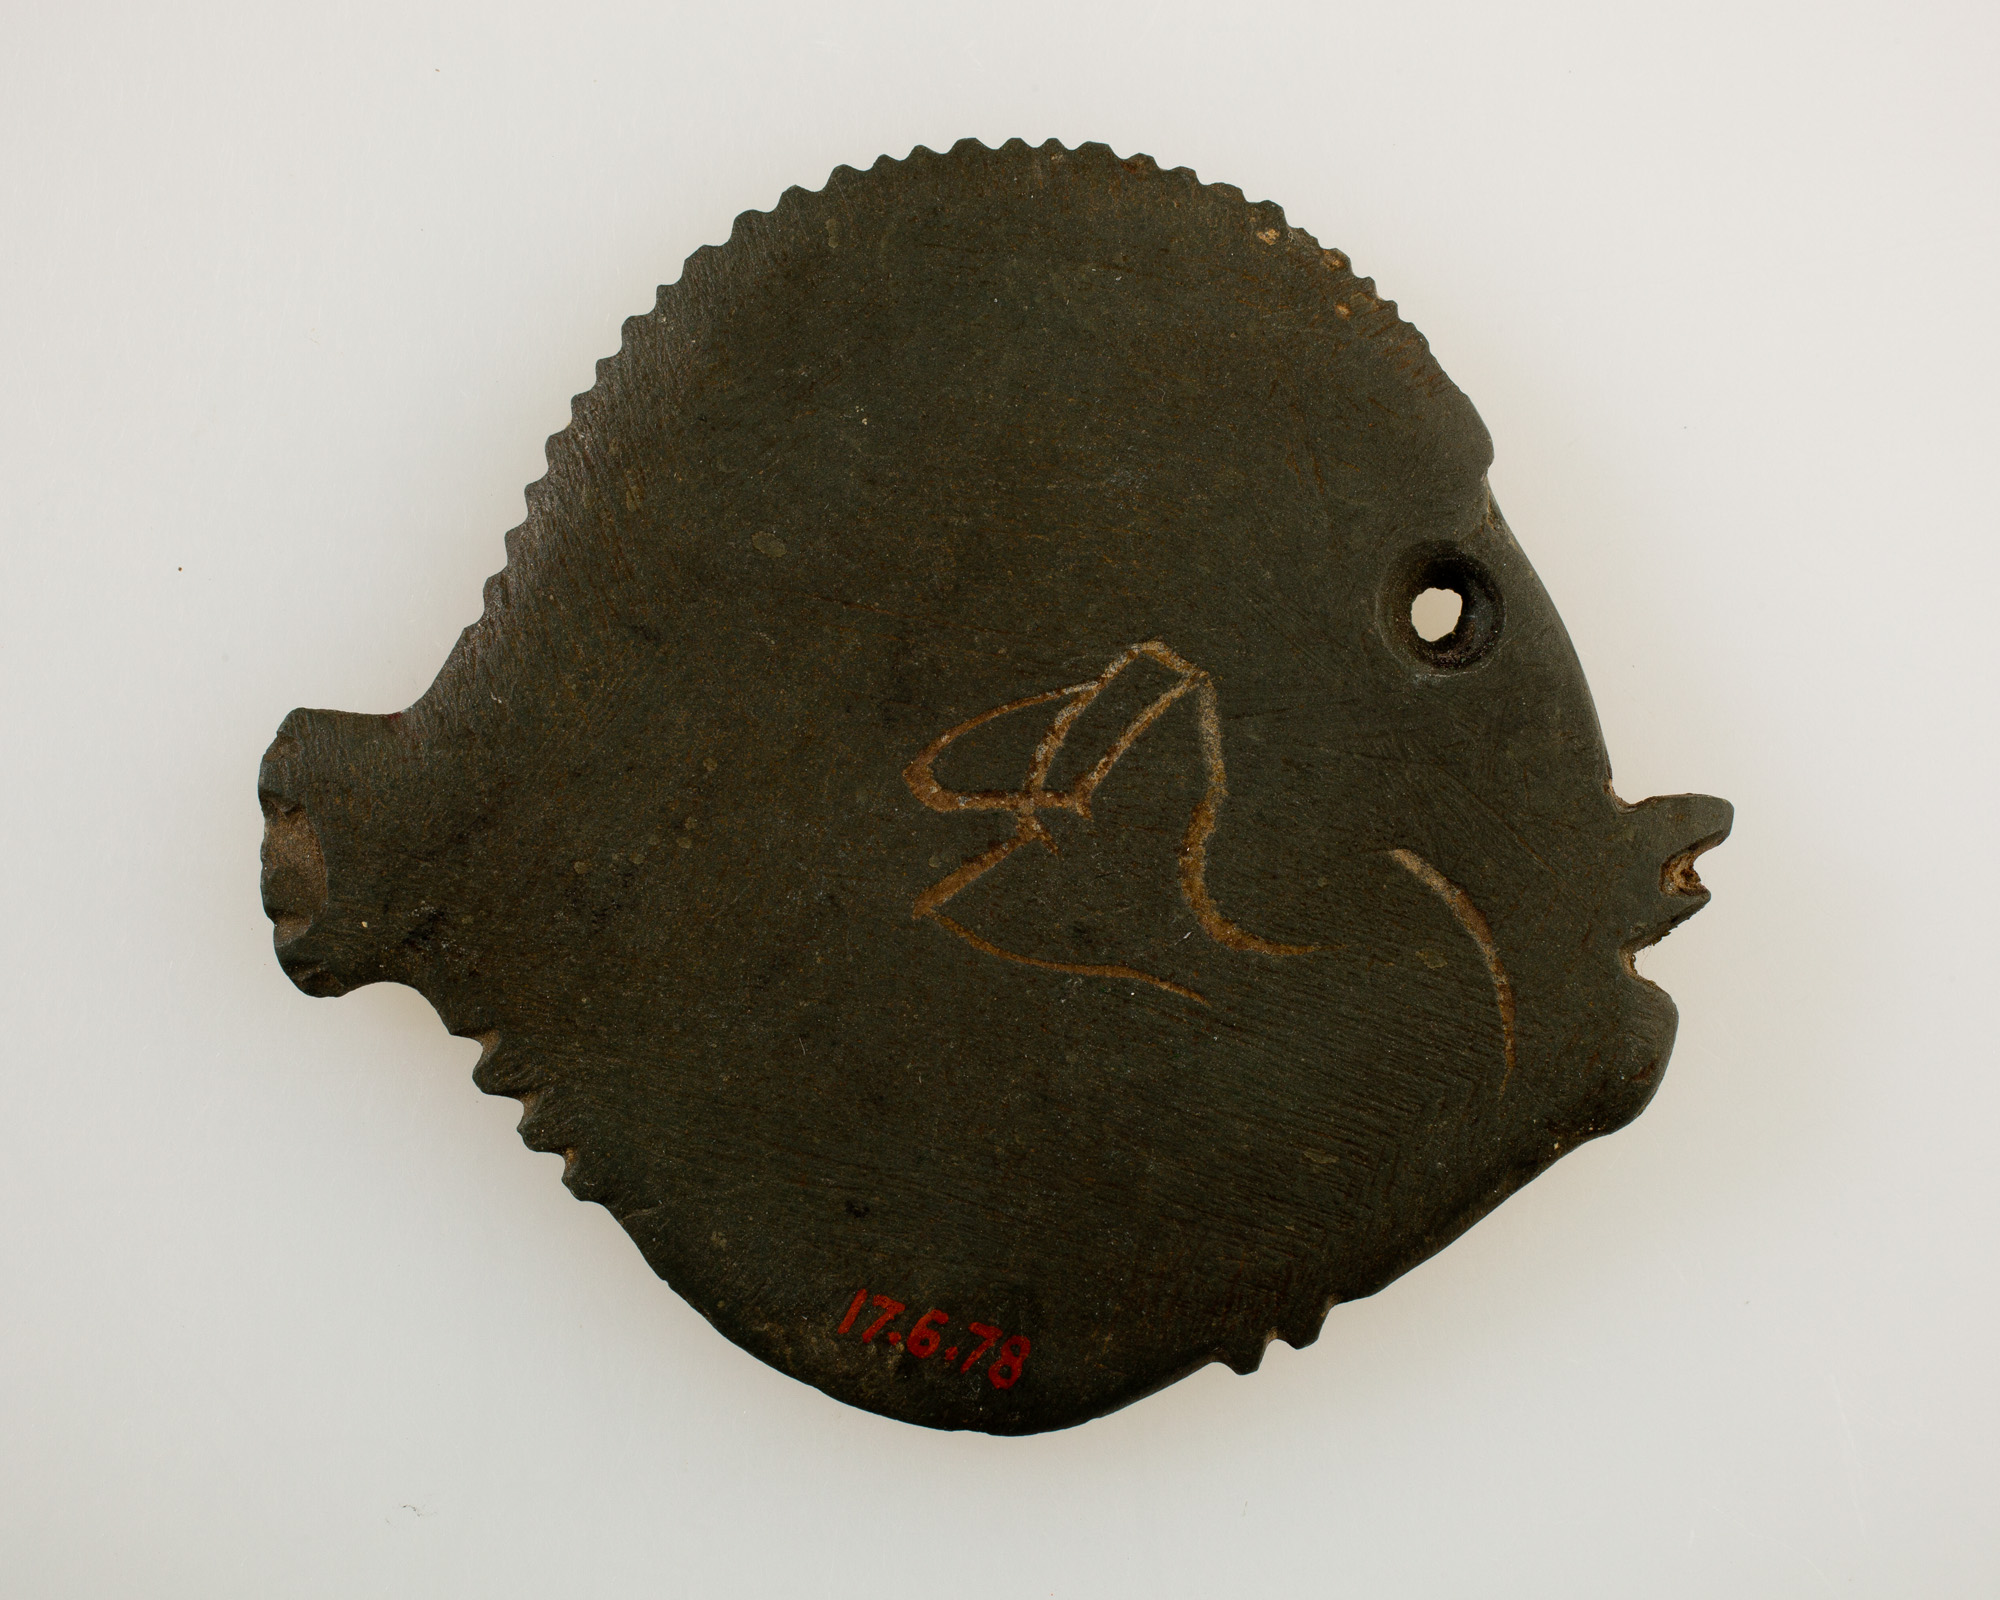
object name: palette, fish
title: Palette in the Form of a Fish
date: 4500-4000 BCE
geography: northern upper egypt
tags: fish